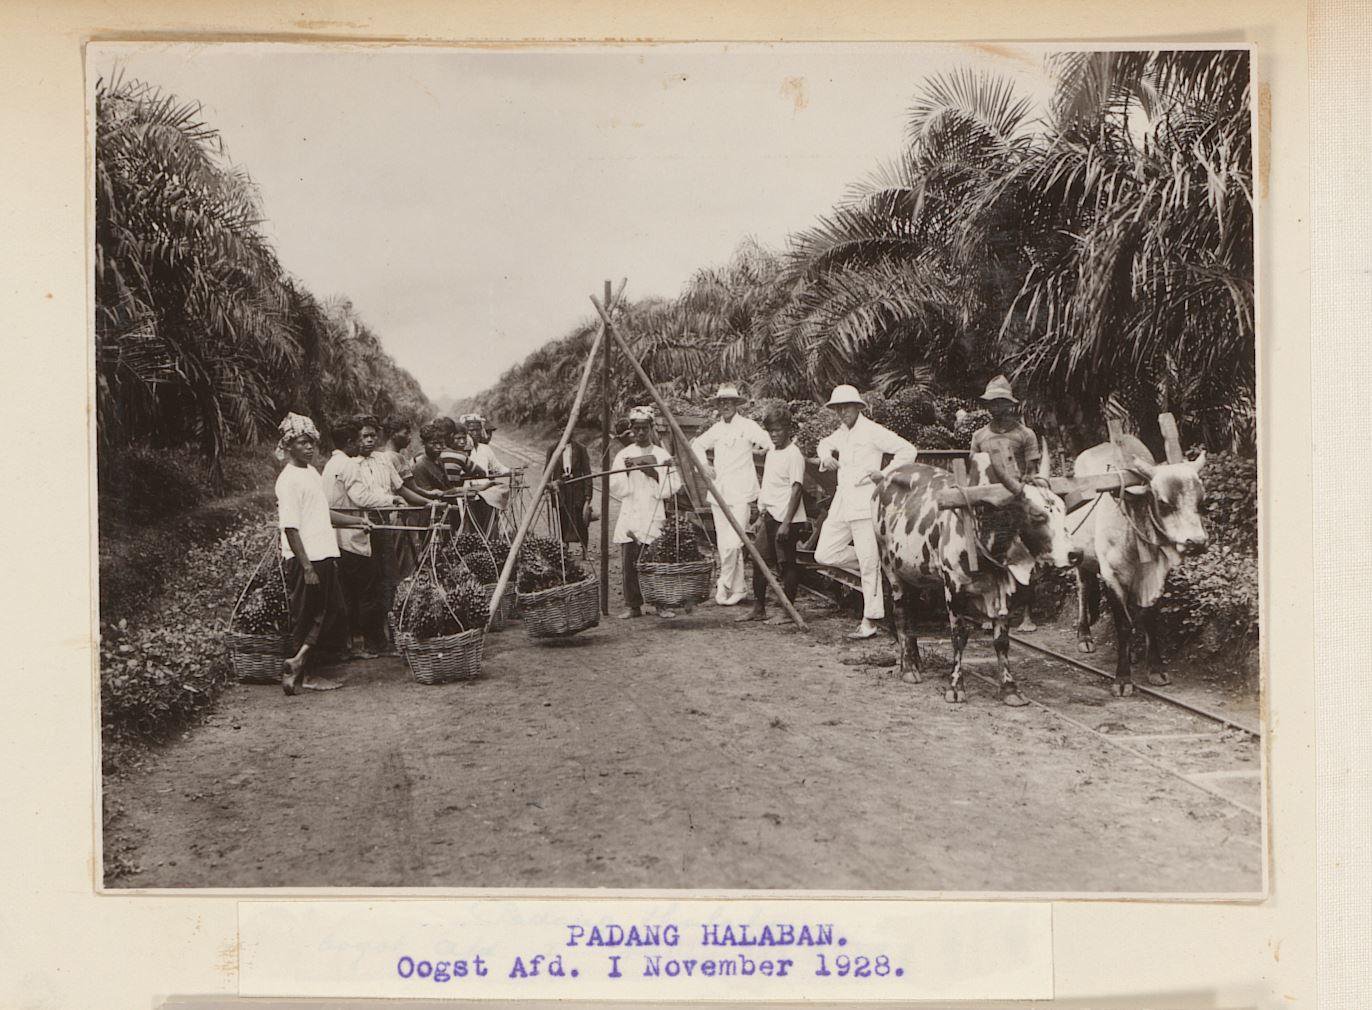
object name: photograph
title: Padang Halaban. Oogst Afd. I November 1928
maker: Anonymous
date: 1928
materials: photographic support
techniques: collodion silver print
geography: east sumatra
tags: asiatic races and peoples (indonesians), plantation, (non-fruit) products of plants or trees: palm oil, sumatra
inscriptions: inscription: ‘Padang Halaban. Oogst Afd. I November 1928’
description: Binnenhalen van de oogst palmolie op de plantage Padang Halaban in november 1928. Arbeiders en opzichters poseren bij draagmanden gevuld met palmnoten bij een door ossen getrokken wagen op het spoor. Onderdeel van het fotoalbum over de plantages Brussel en Pernantian van de Sumatra Caoutchouc Maatschappij op de Oostkust van Sumatra in de jaren 1910-1935.